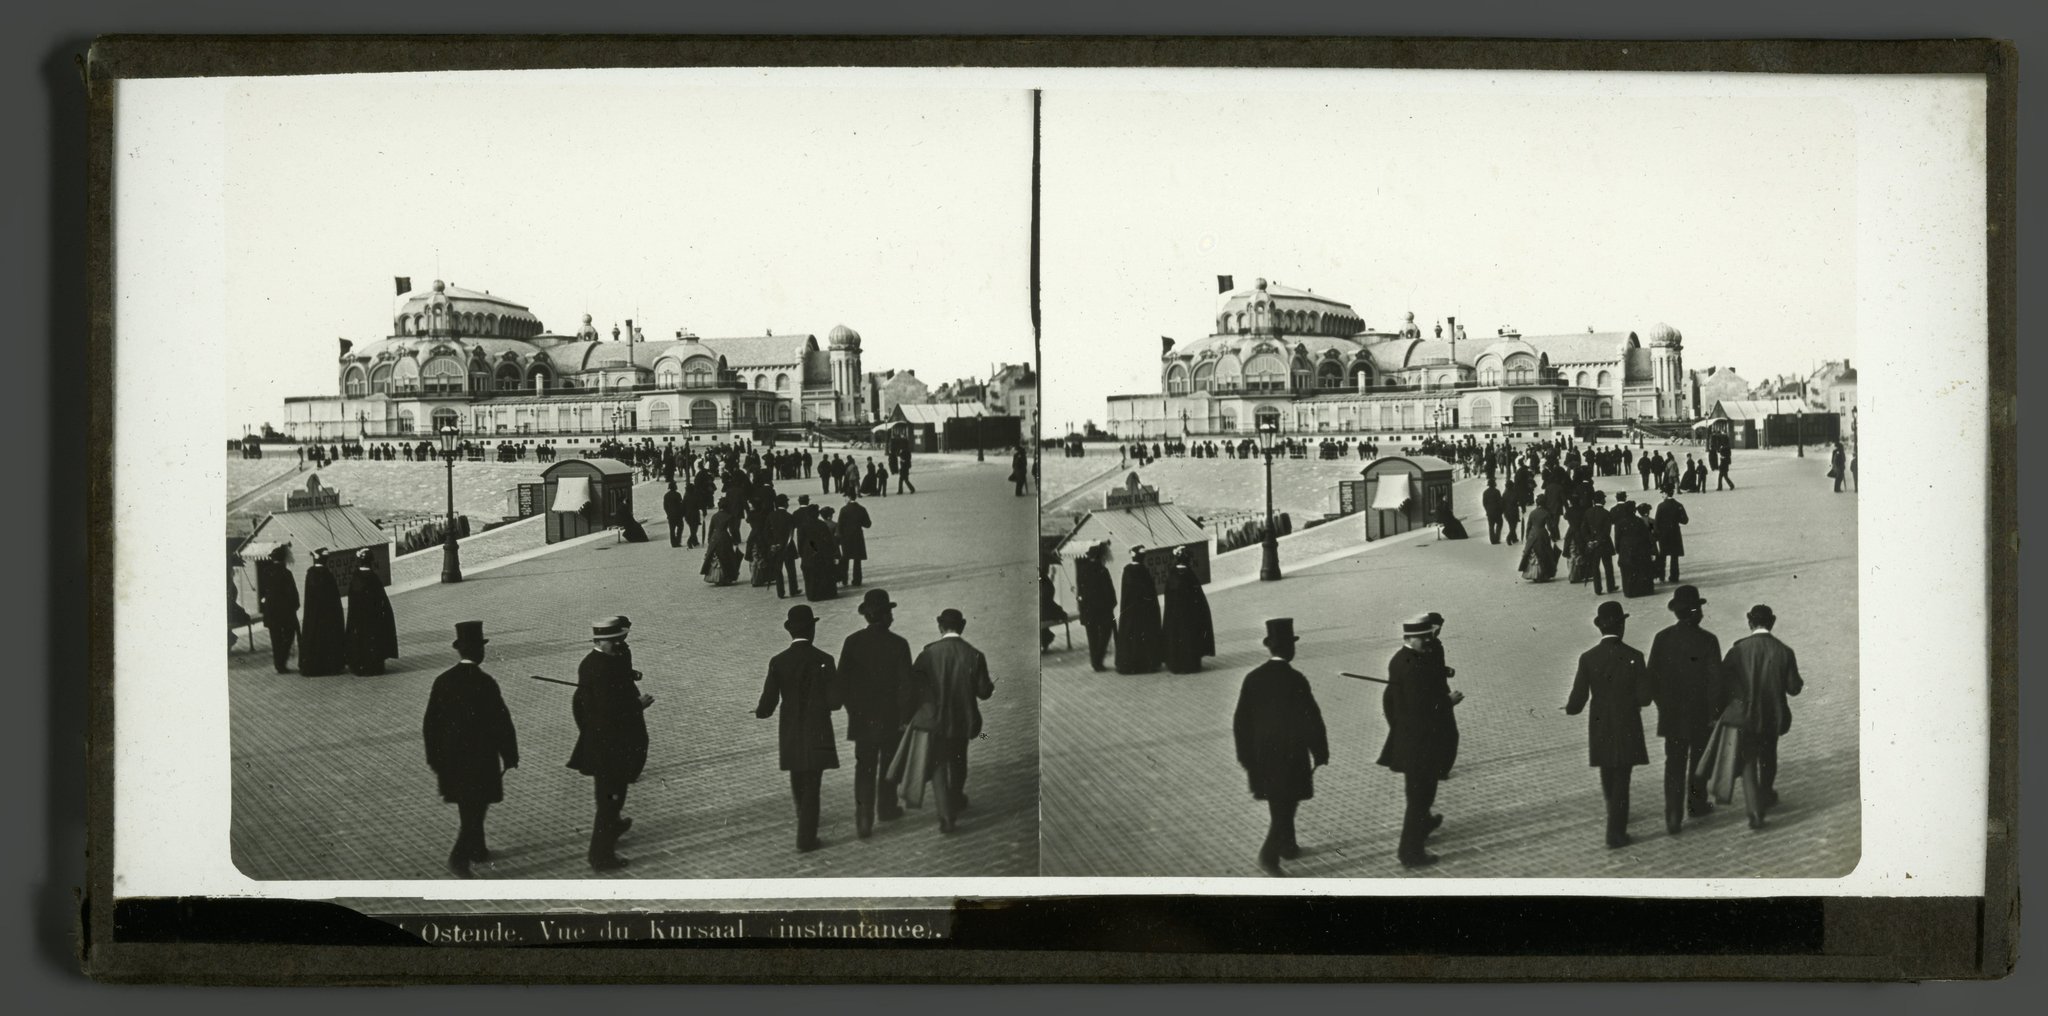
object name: photograph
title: Ostende. Vue du Kursaal. (instantanée)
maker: Anonymous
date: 1877-1890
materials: glass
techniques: slide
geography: oostende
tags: watering-place, spa, avenue, boulevard, promenade, esplanade